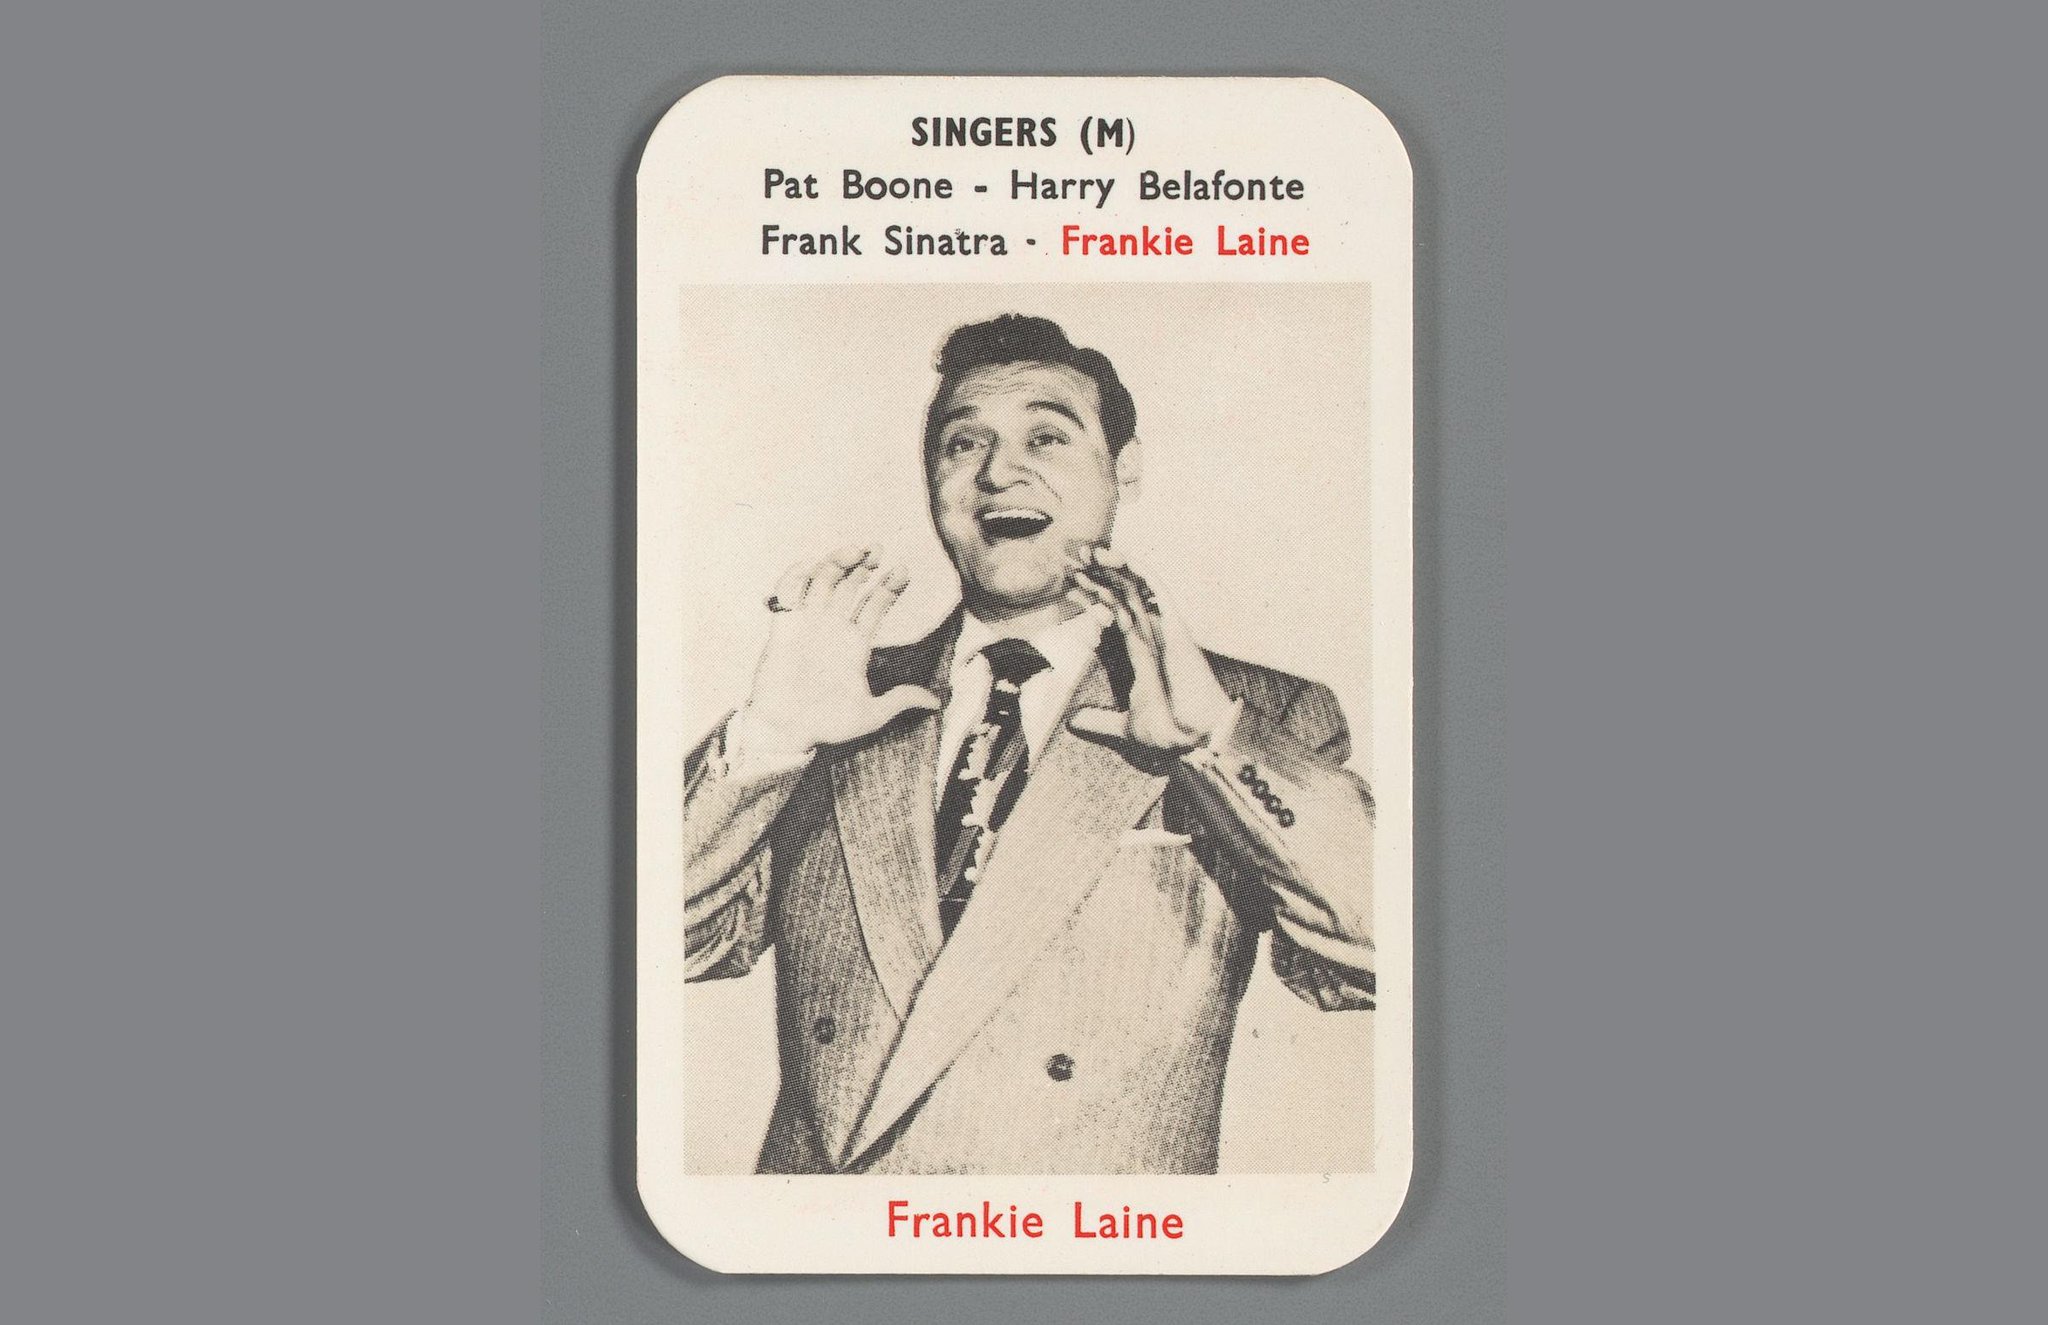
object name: photomechanical print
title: Frankie Laine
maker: Anonymous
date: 1960-1970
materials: paper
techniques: autotype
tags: musician, portrait of a musician